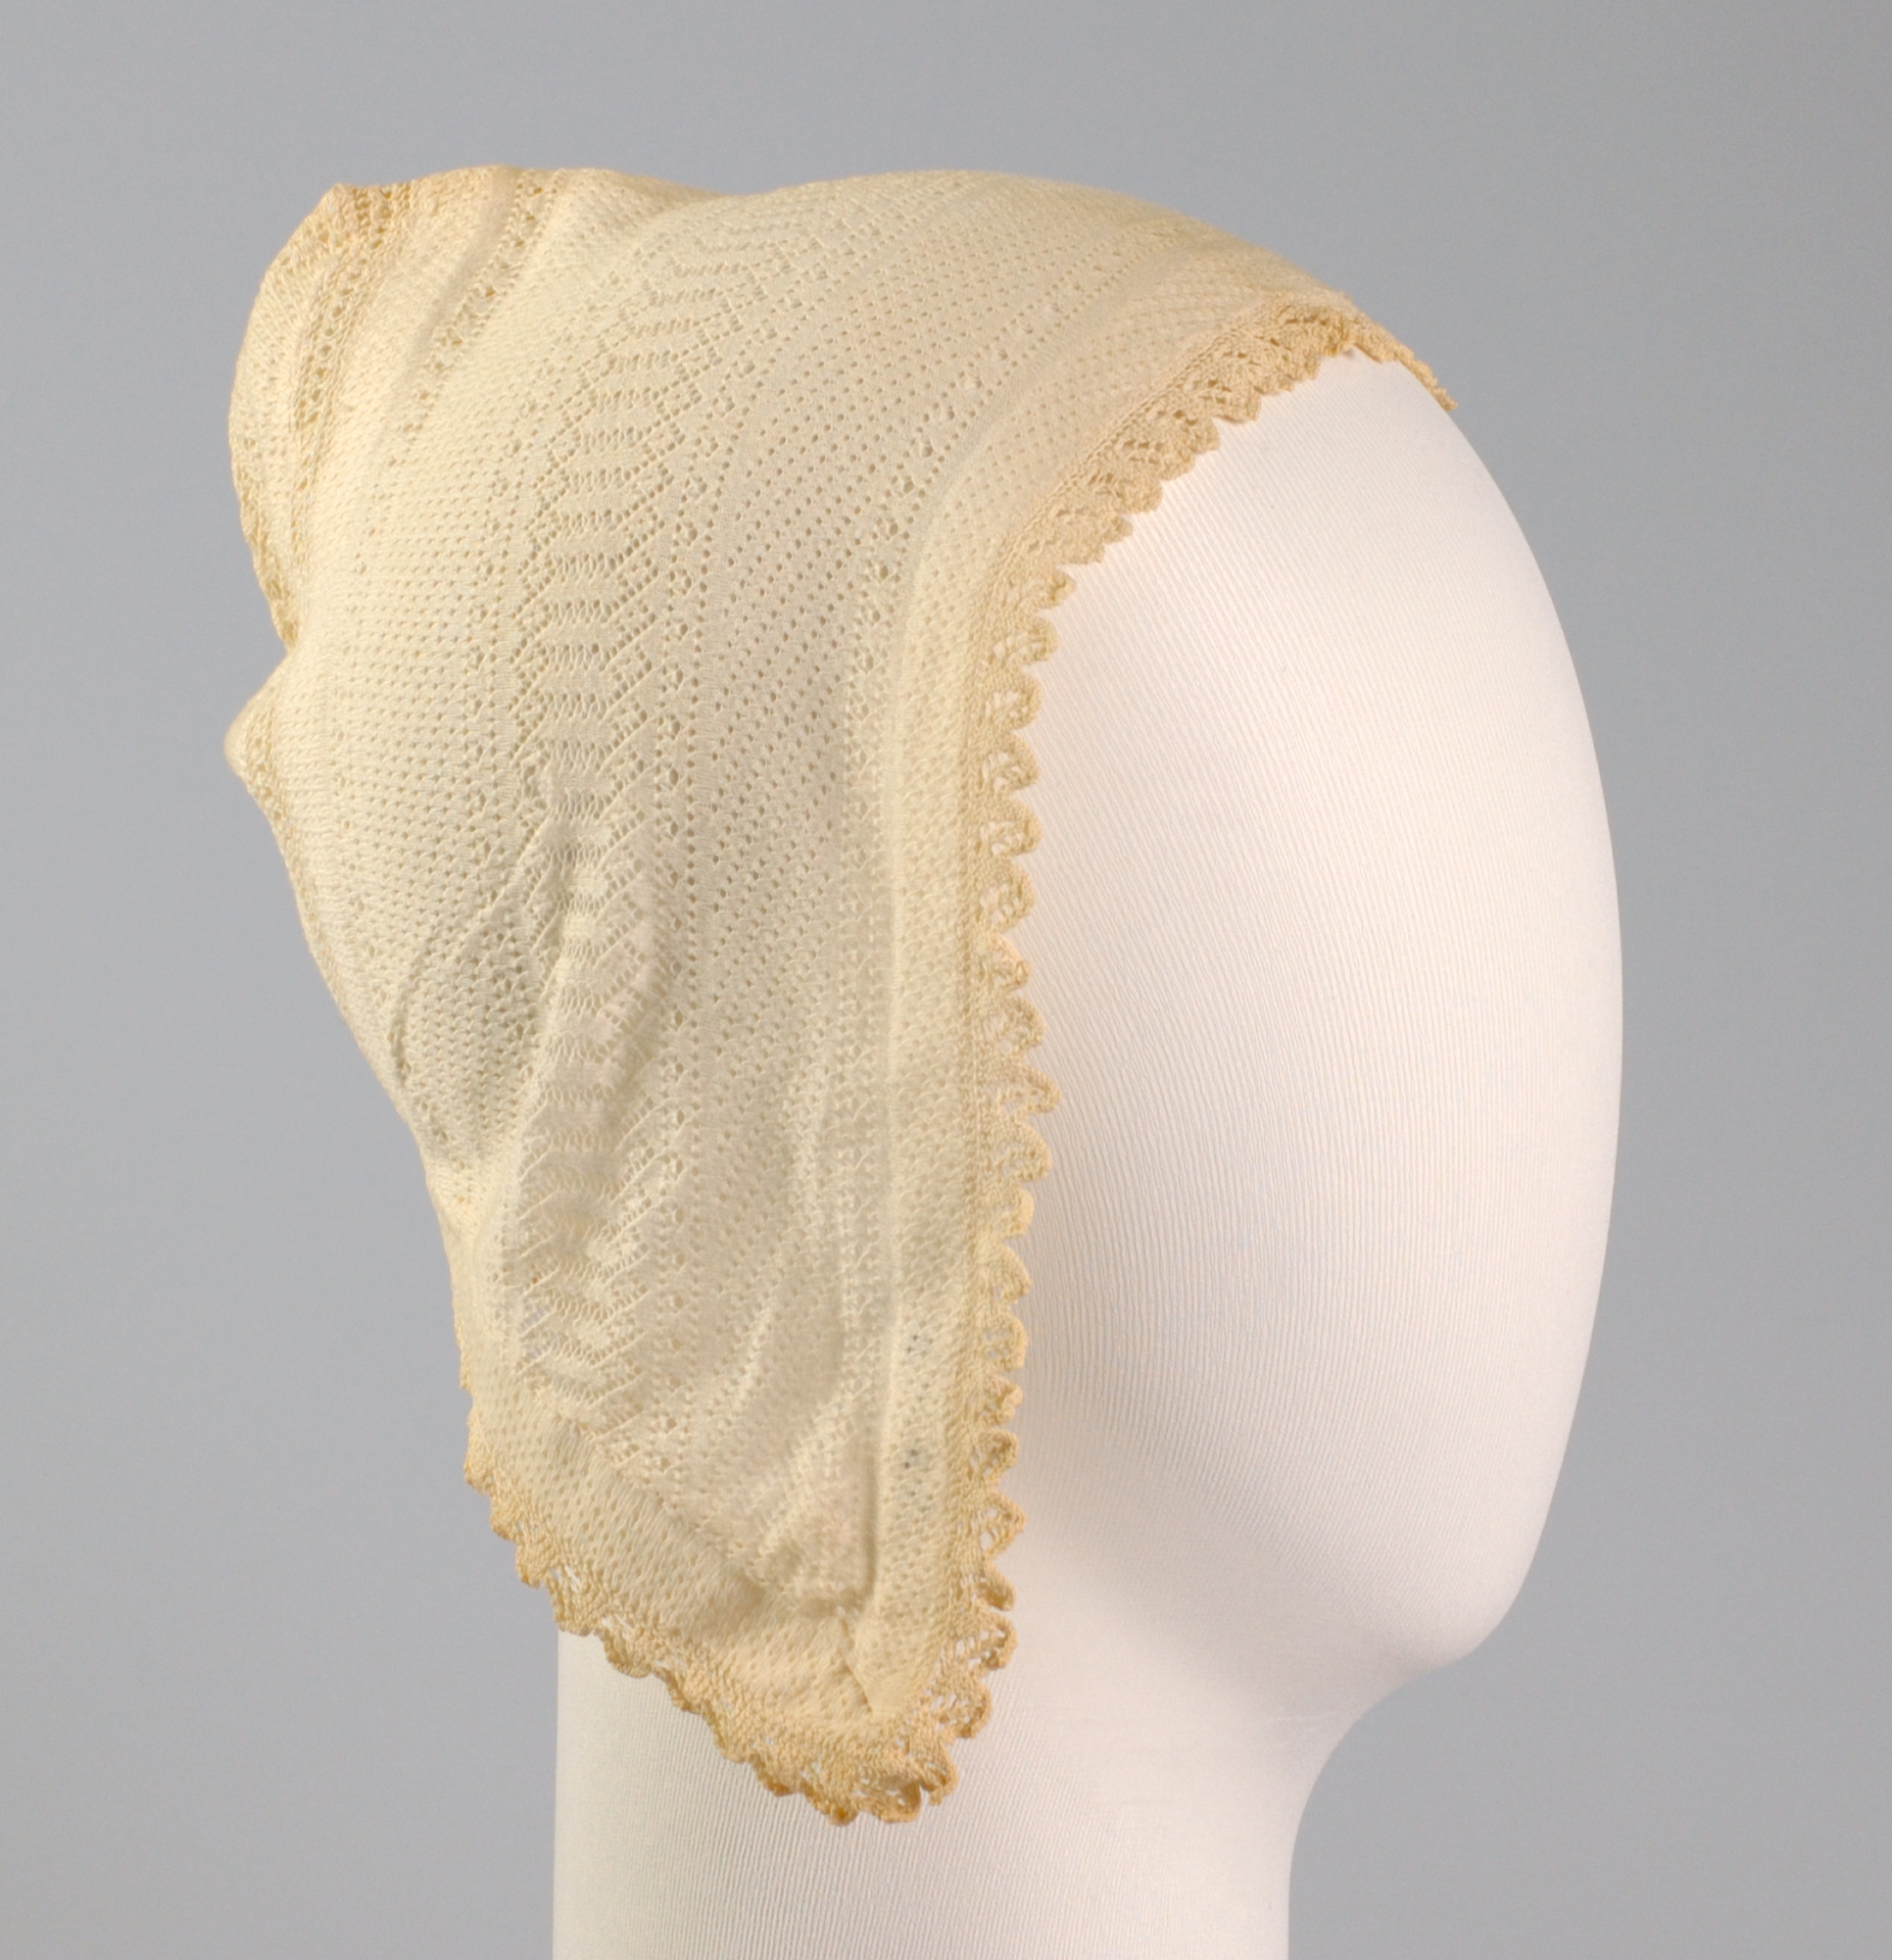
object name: nightcap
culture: american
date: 1850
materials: cotton